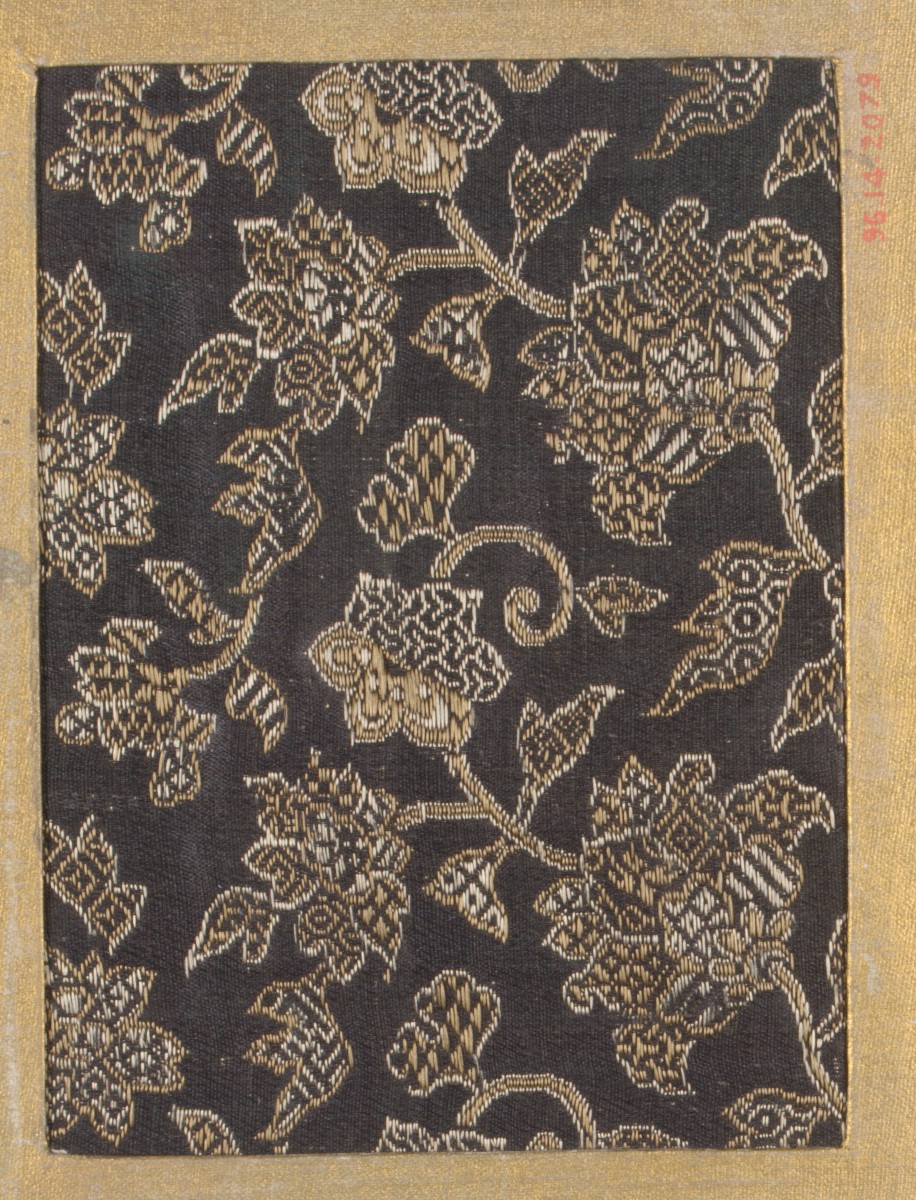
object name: piece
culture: japanese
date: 1701-1900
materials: silk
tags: leaves